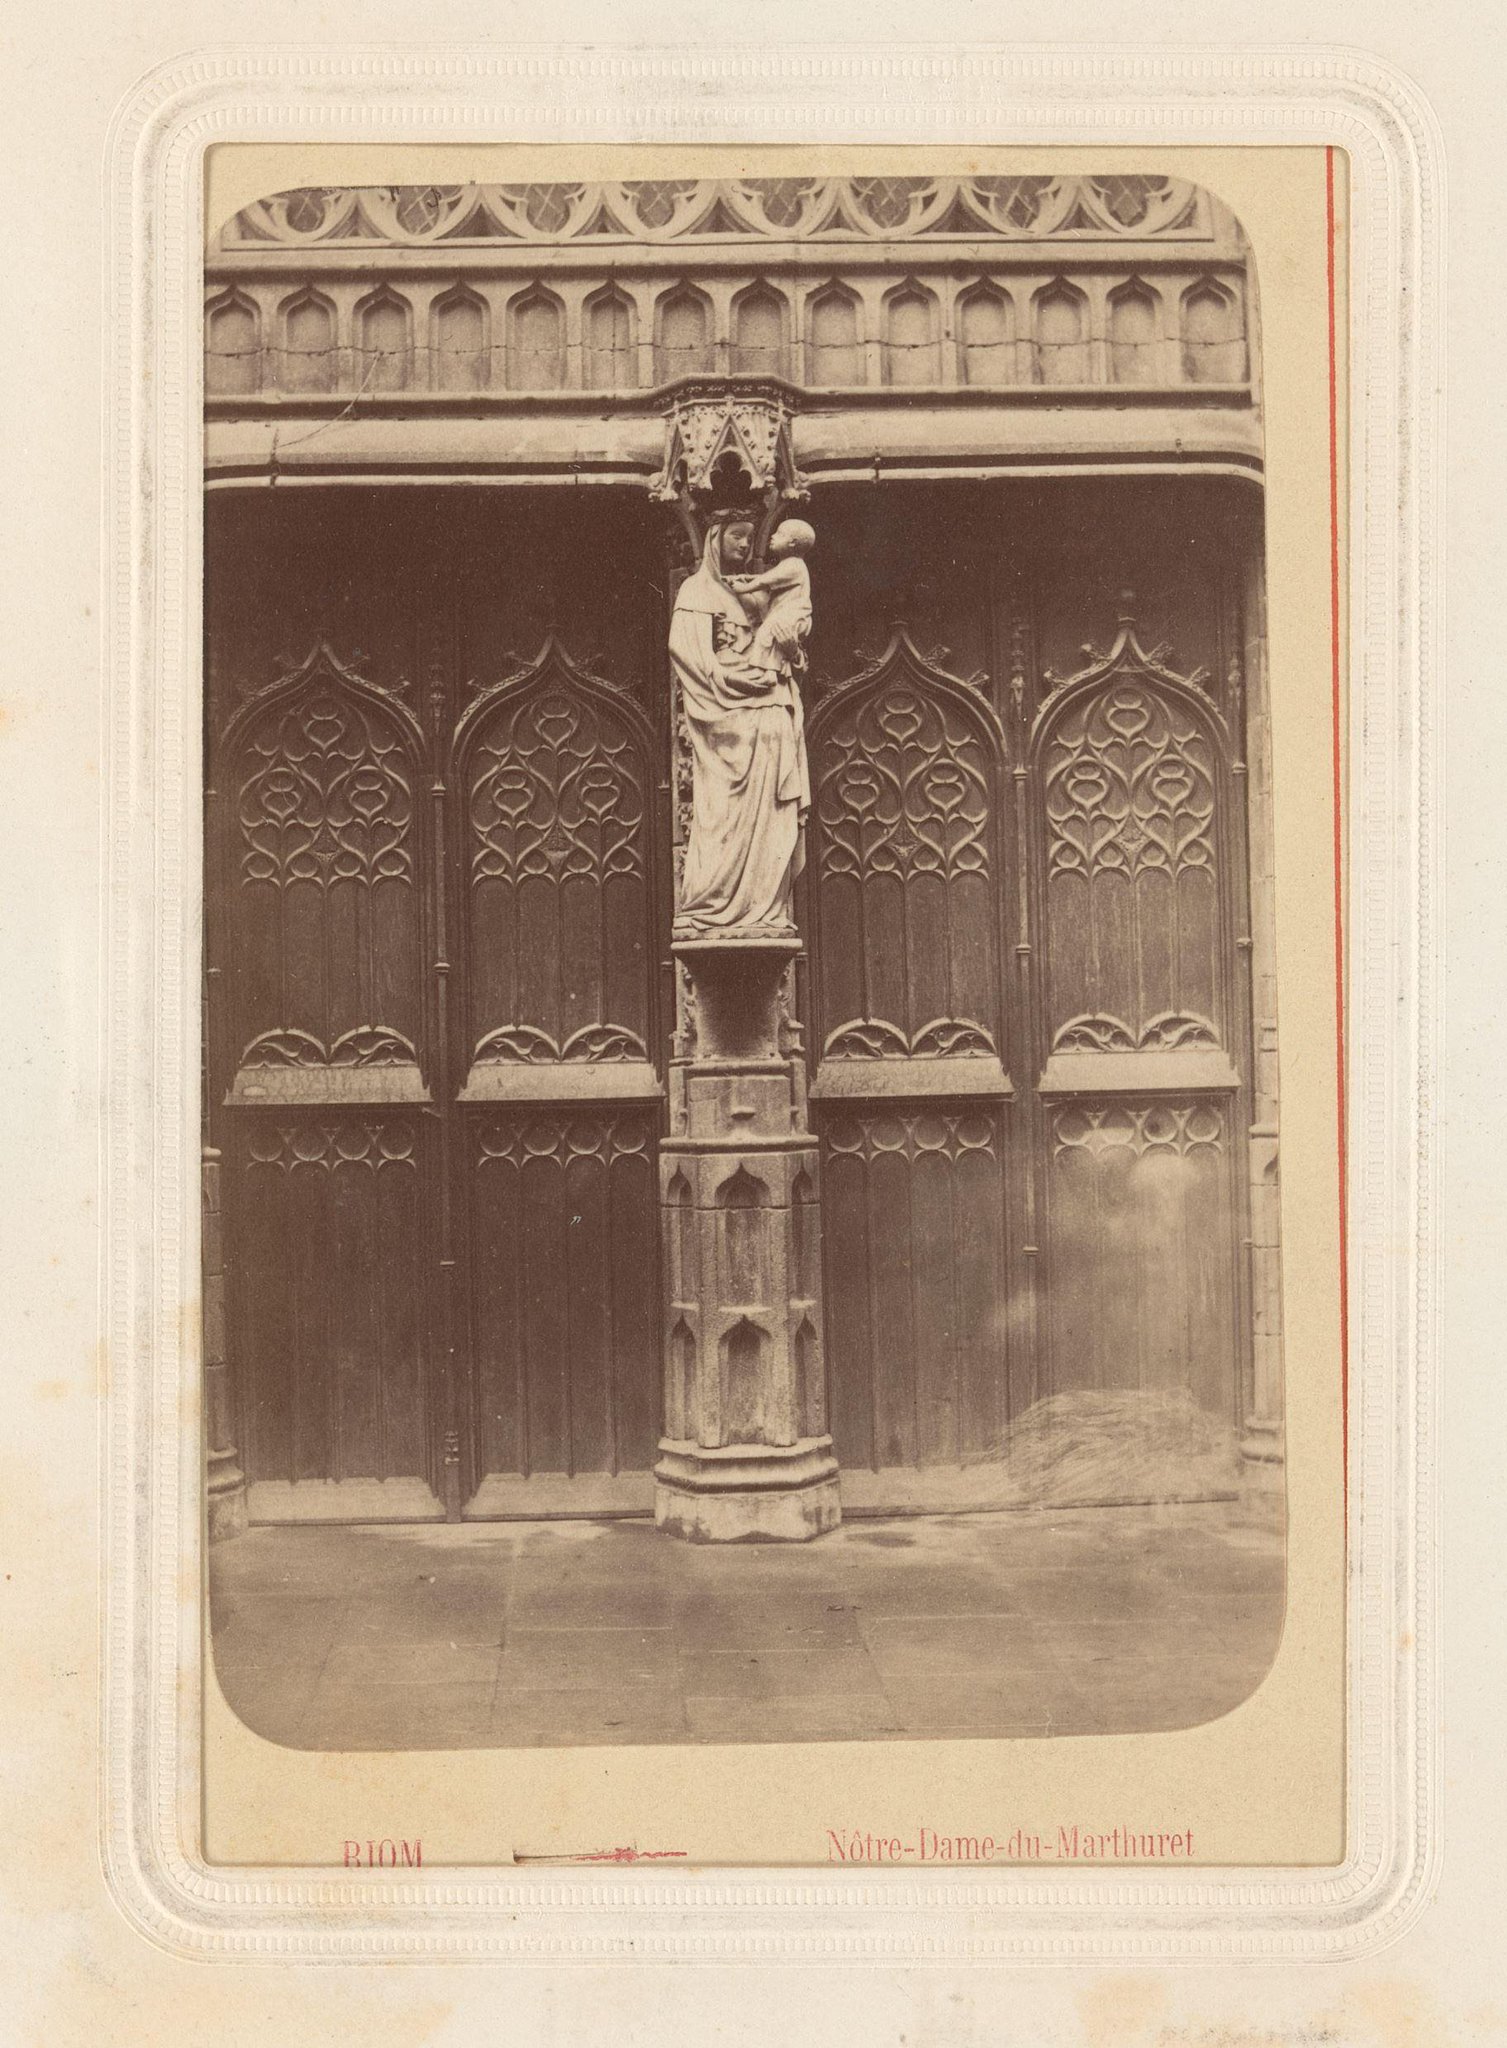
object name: album leaf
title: Nôtre-Dam-du-Marthuret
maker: Anonymous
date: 1867-1900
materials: cardboard, paper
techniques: albumen print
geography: riom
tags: parts of church exterior and annexes: portal, sculpture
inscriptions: inscription: ‘RIOM’